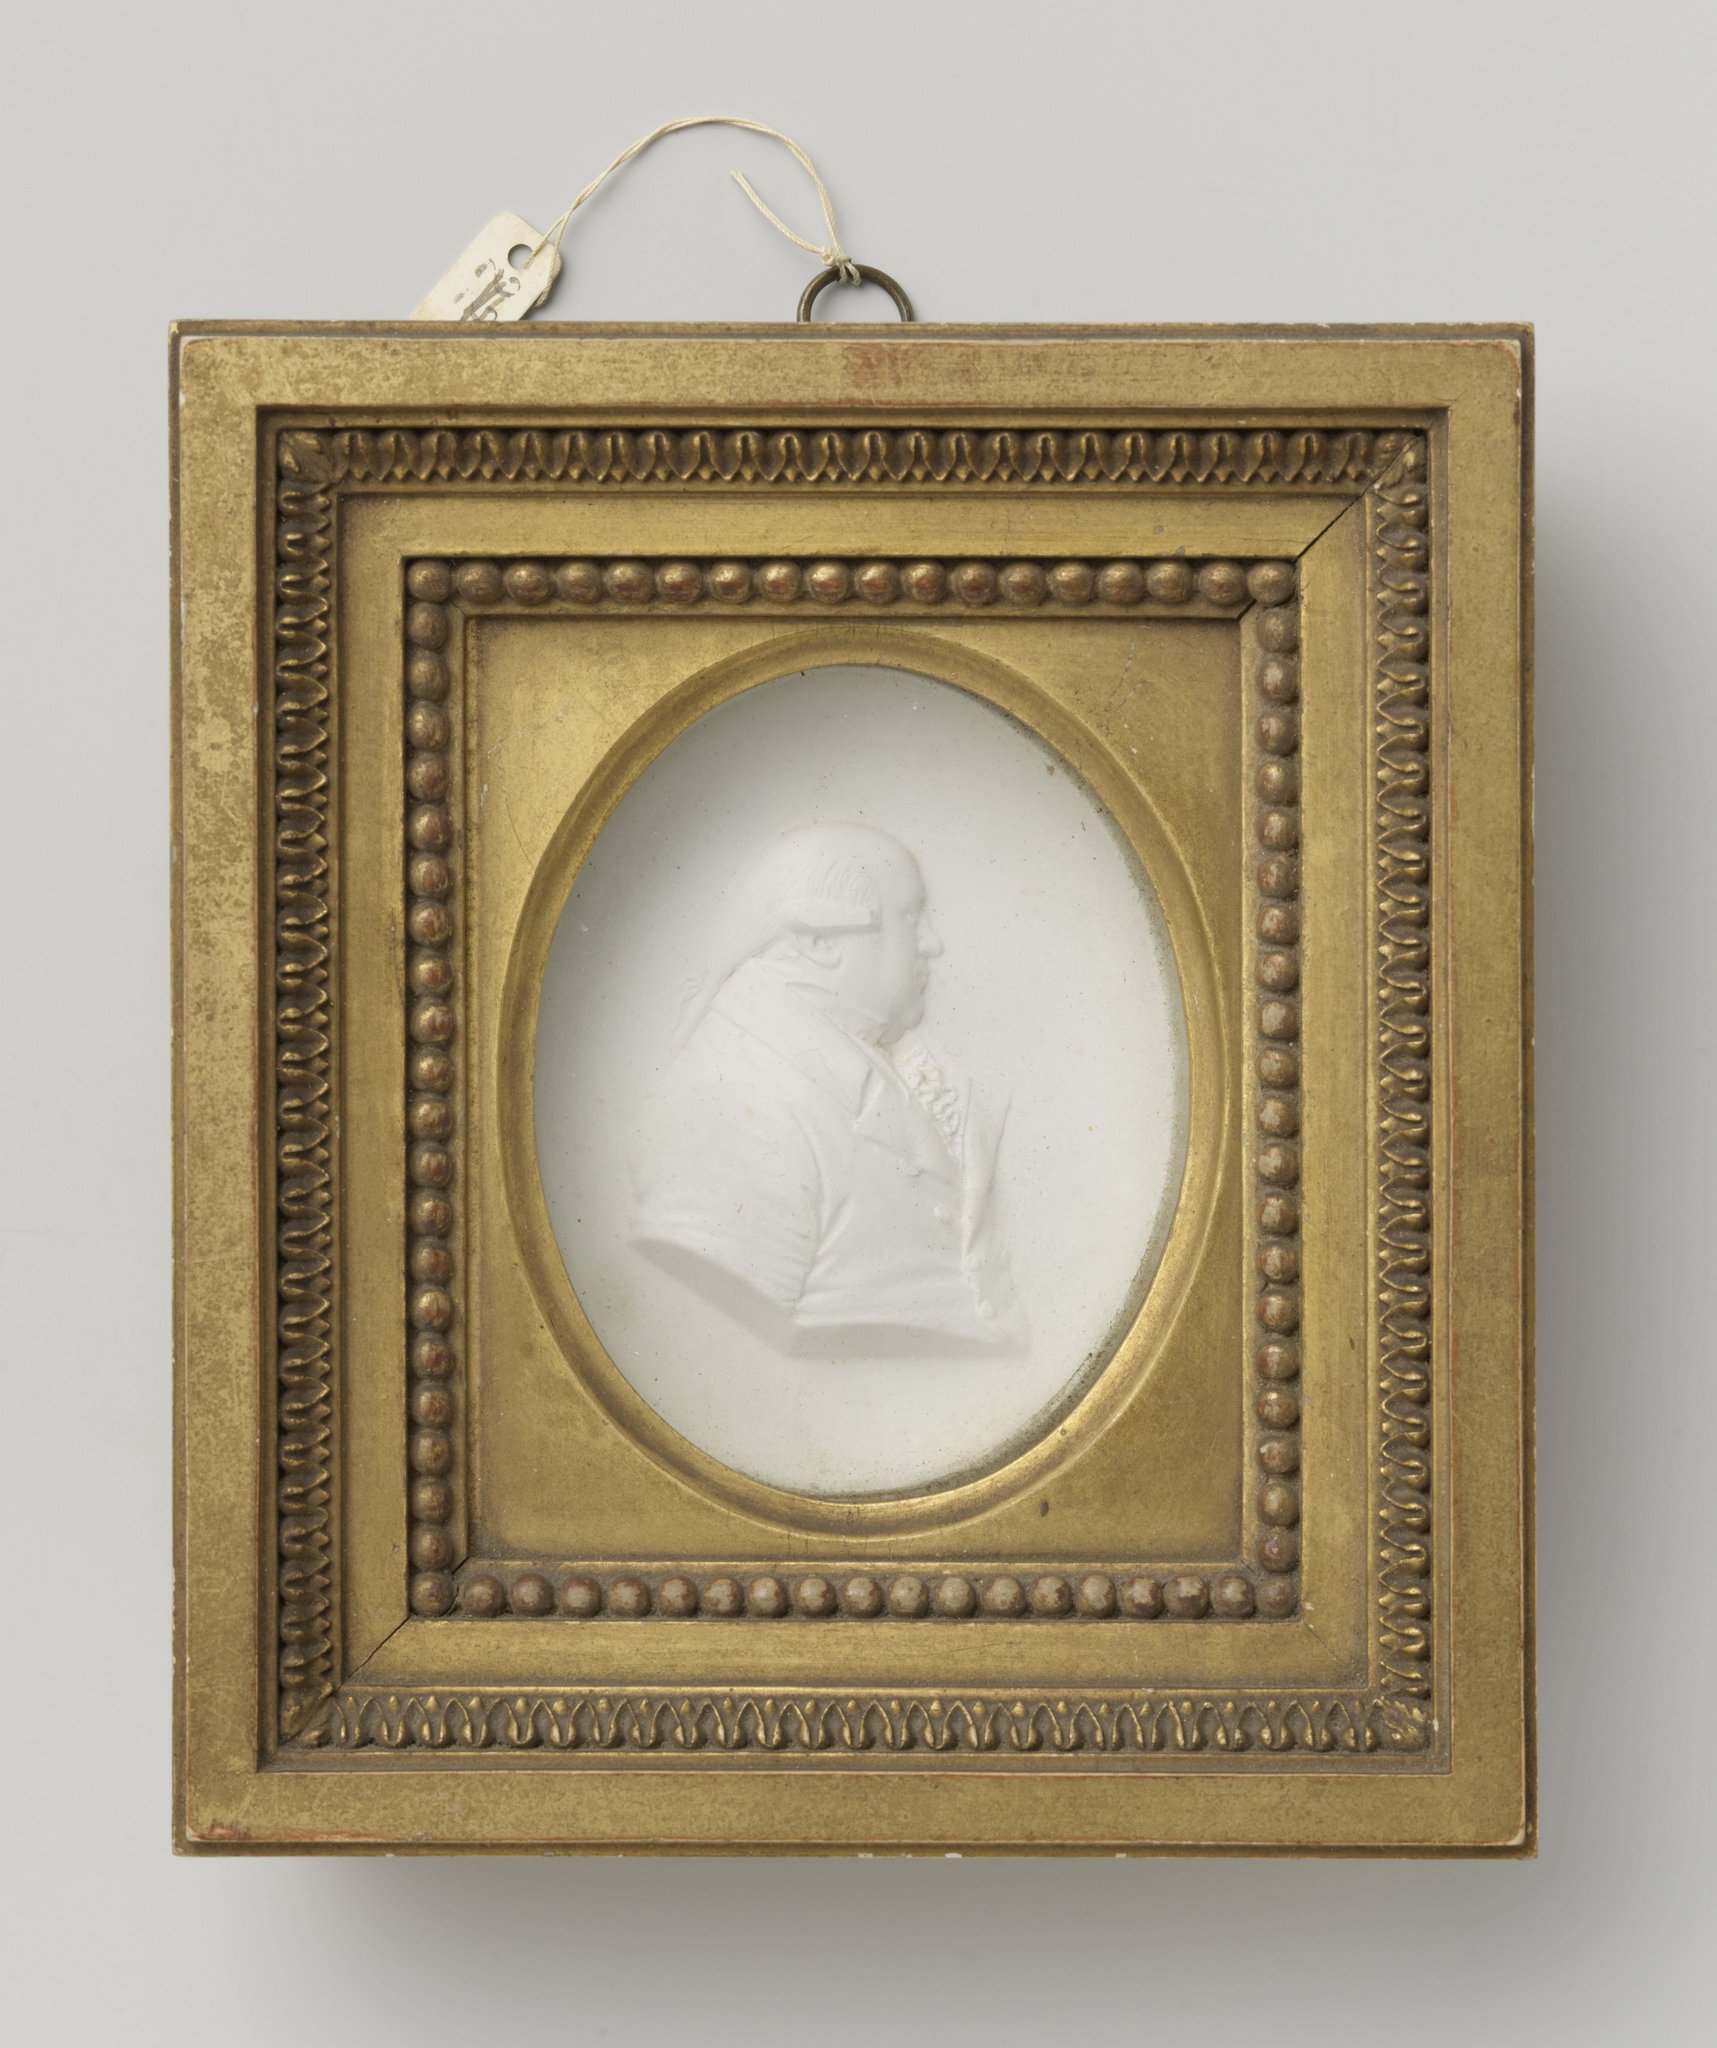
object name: sculpture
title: Medaillonportret vermoedelijk van Frederik Willem II van Pruissen, 1744 - 1797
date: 1770-1780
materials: gypsum, wood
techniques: framing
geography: germany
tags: berlin, frederik willem ii (koning van pruisen), historical persons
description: Portret van een man (wellicht Frederik Willem II van Pruissen, 1744 - 1797) in gips in een verguld houten lijstje. Borststuk naar rechts, en profiel, gekleed in jas en met pruik. Ovaal. Versierde en vergulde houten lijst rechthoekig.